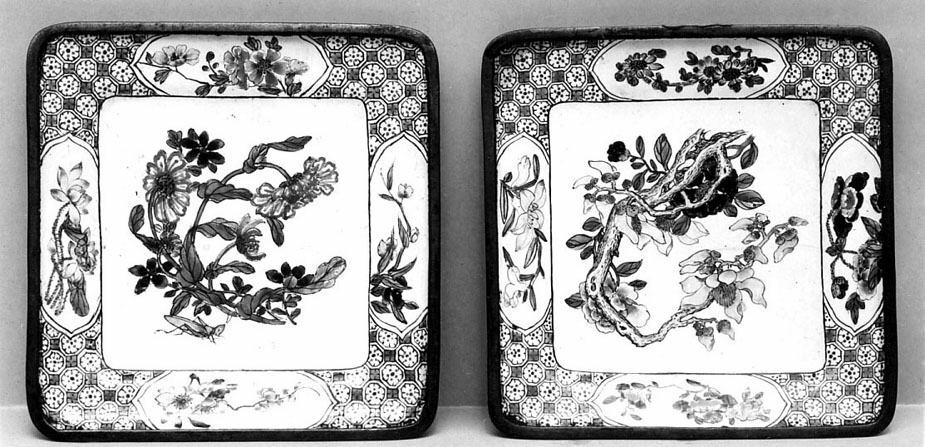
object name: dish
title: Square Dish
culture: chinese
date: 1736-1795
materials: enamel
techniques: painting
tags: flowers,plants